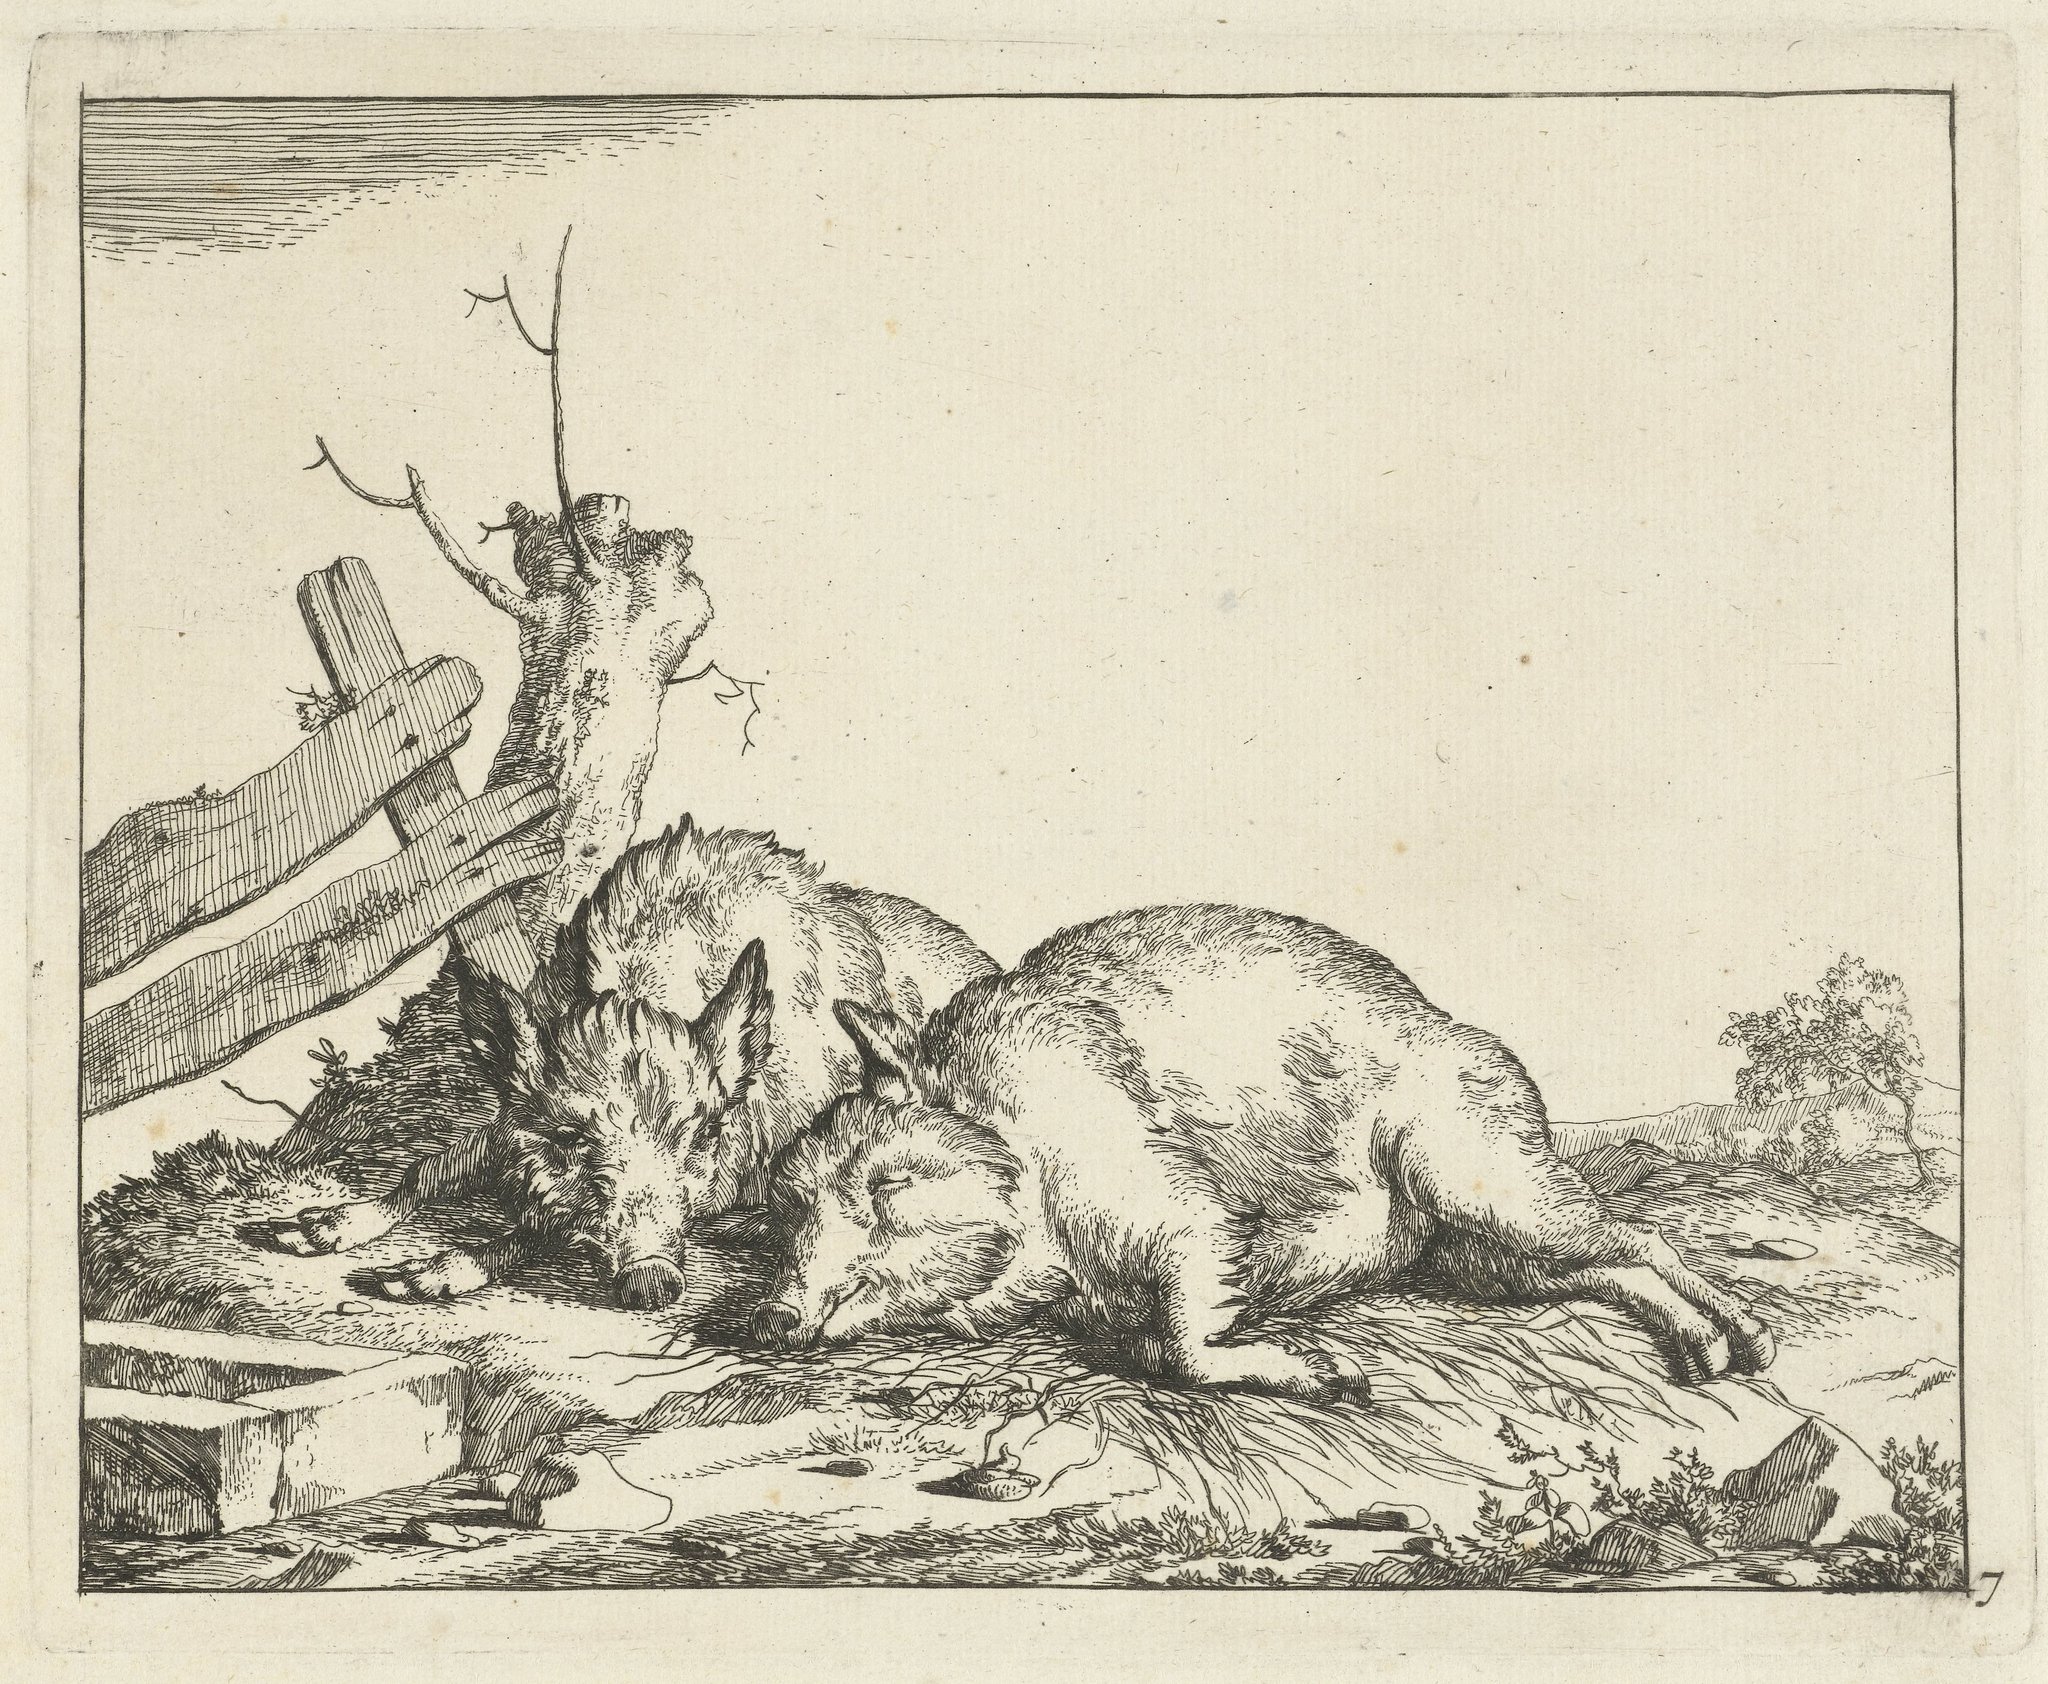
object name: print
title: Roofdieren en zwijnen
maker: marcus de bye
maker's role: print maker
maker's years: 1639-1688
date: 1657-1677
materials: paper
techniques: etching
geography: the hague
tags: pig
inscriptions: collector's mark: Lugt 240